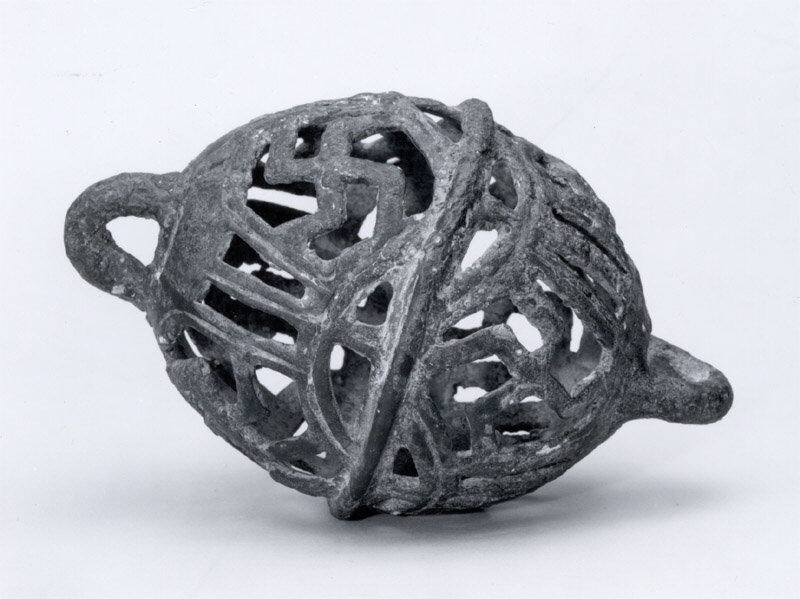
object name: rattle bell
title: Openwork rattle bell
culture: iranian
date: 900-701 BCE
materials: bronze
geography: iran